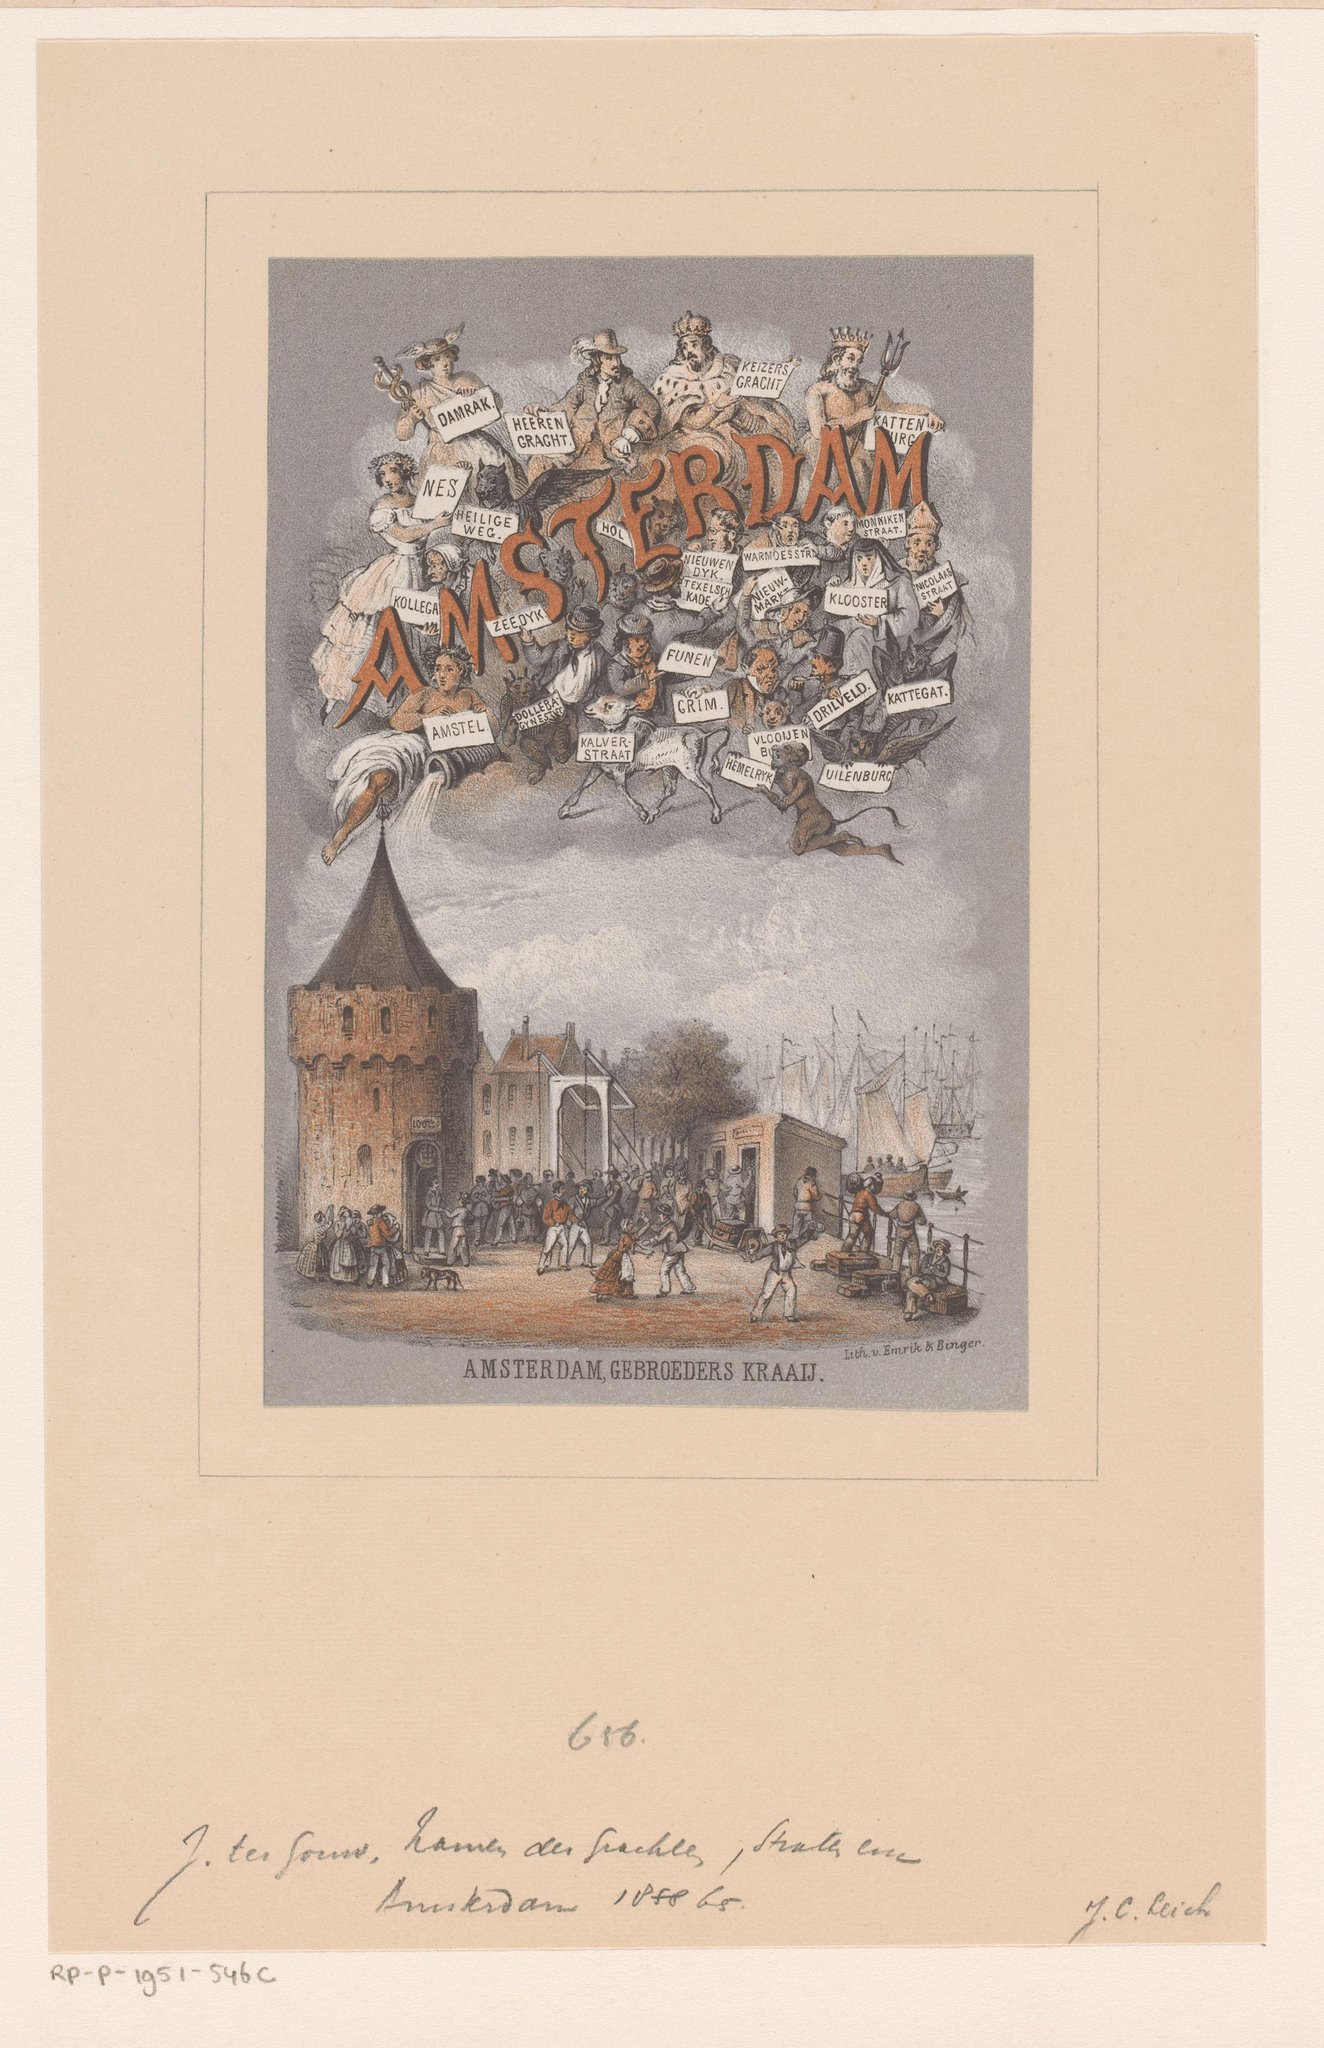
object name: wrapper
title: Omslag voor: Amsterdam. Oorsprong en afleiding van de namen der grachten, eilanden, pleinen, straten, stegen, bruggen, sluizen en torens dezer stad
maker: johan coenraad leich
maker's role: draughtsman, print maker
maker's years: 1823-1890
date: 1865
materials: paper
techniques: tone lithography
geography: amsterdam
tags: city-view in general; 'veduta', amsterdam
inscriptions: collector's mark: Lugt 2228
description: Deze prent is gepubliceerd in: J. ter Gouw, Amsterdam. Oorsprong en afleiding van de namen der grachten, eilanden, pleinen, straten, stegen, bruggen, sluizen en torens dezer stad, II, Amsterdam: C.L. Brinkman, 1865.